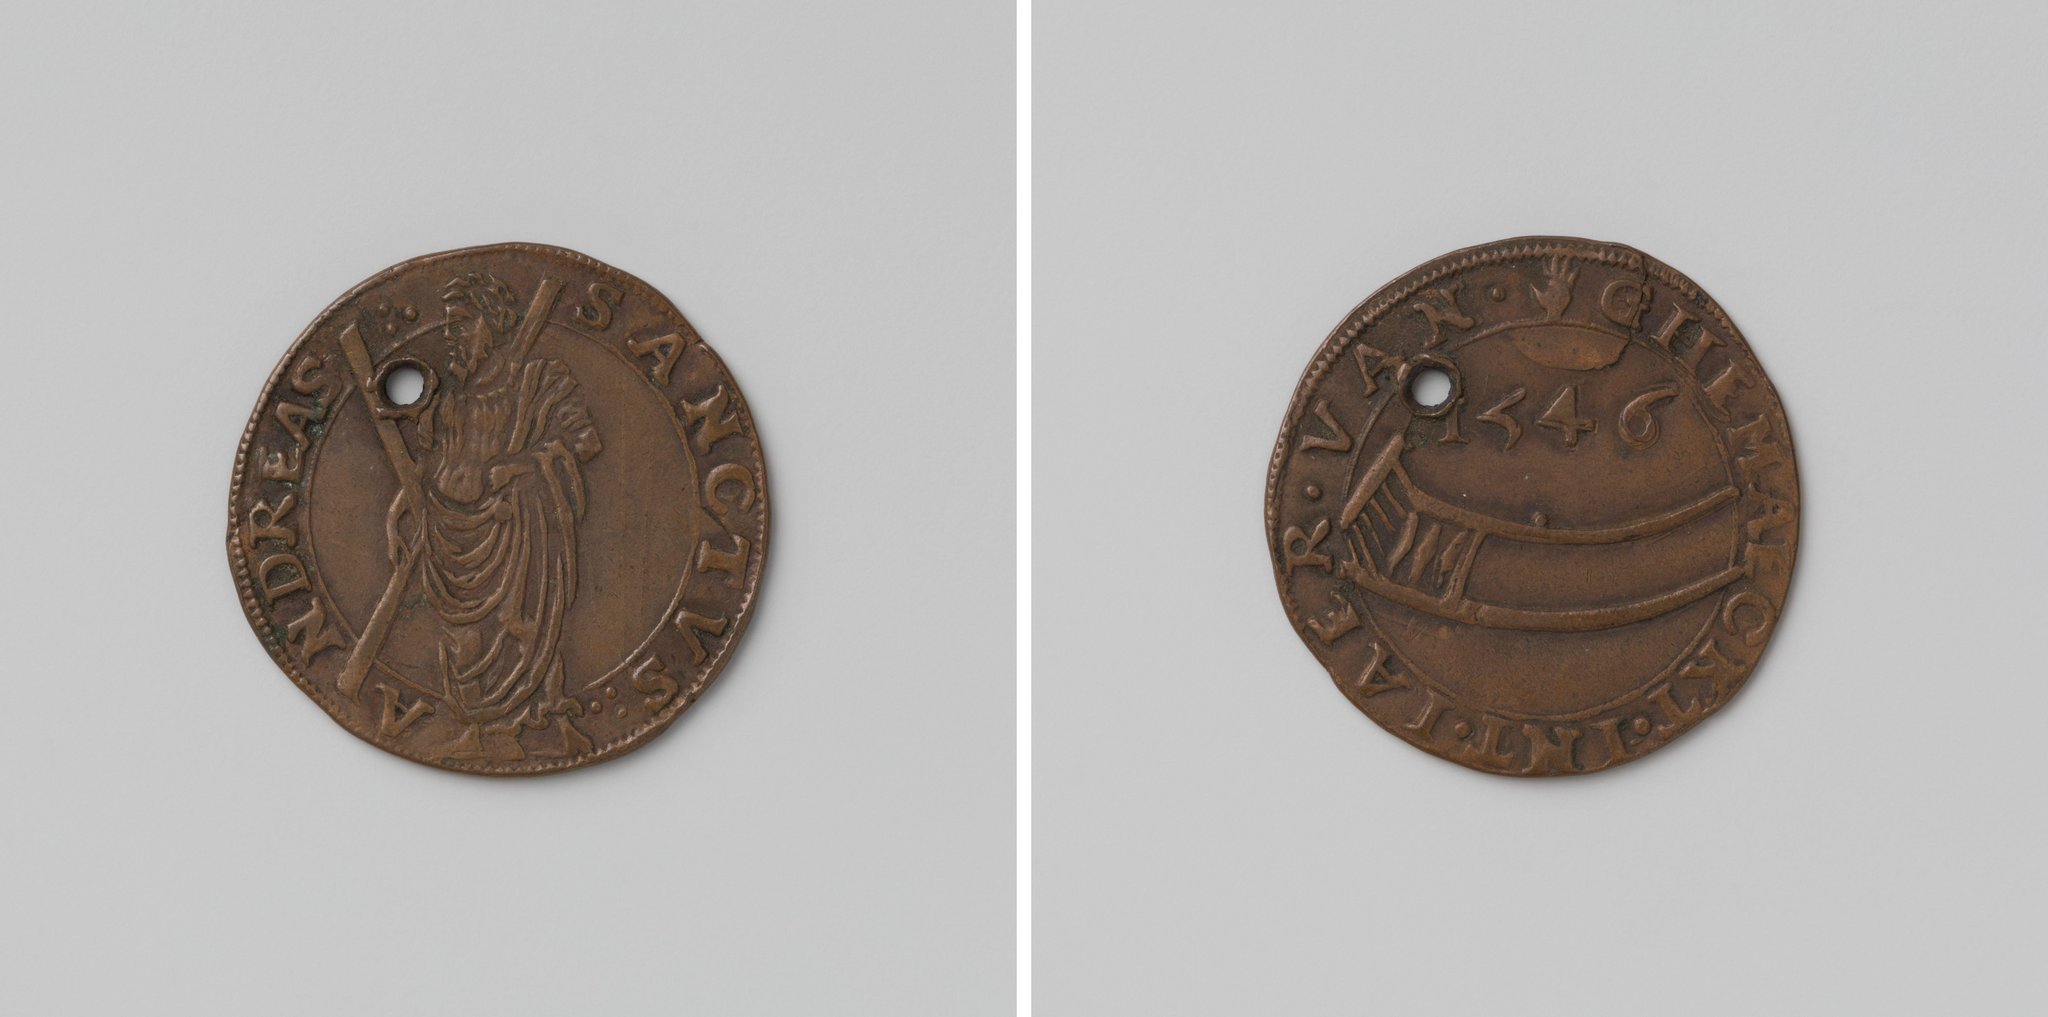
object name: medal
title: Sint Andreas- of kruiersgilde van Antwerpen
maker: Anonymous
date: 1546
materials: copper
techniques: striking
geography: antwerp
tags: antwerp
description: Koperen penning met gat erin. Voorzijde: Andreas met kruis binnen omschrift. Keerzijde: sleep onder jaartal binnen omschrift